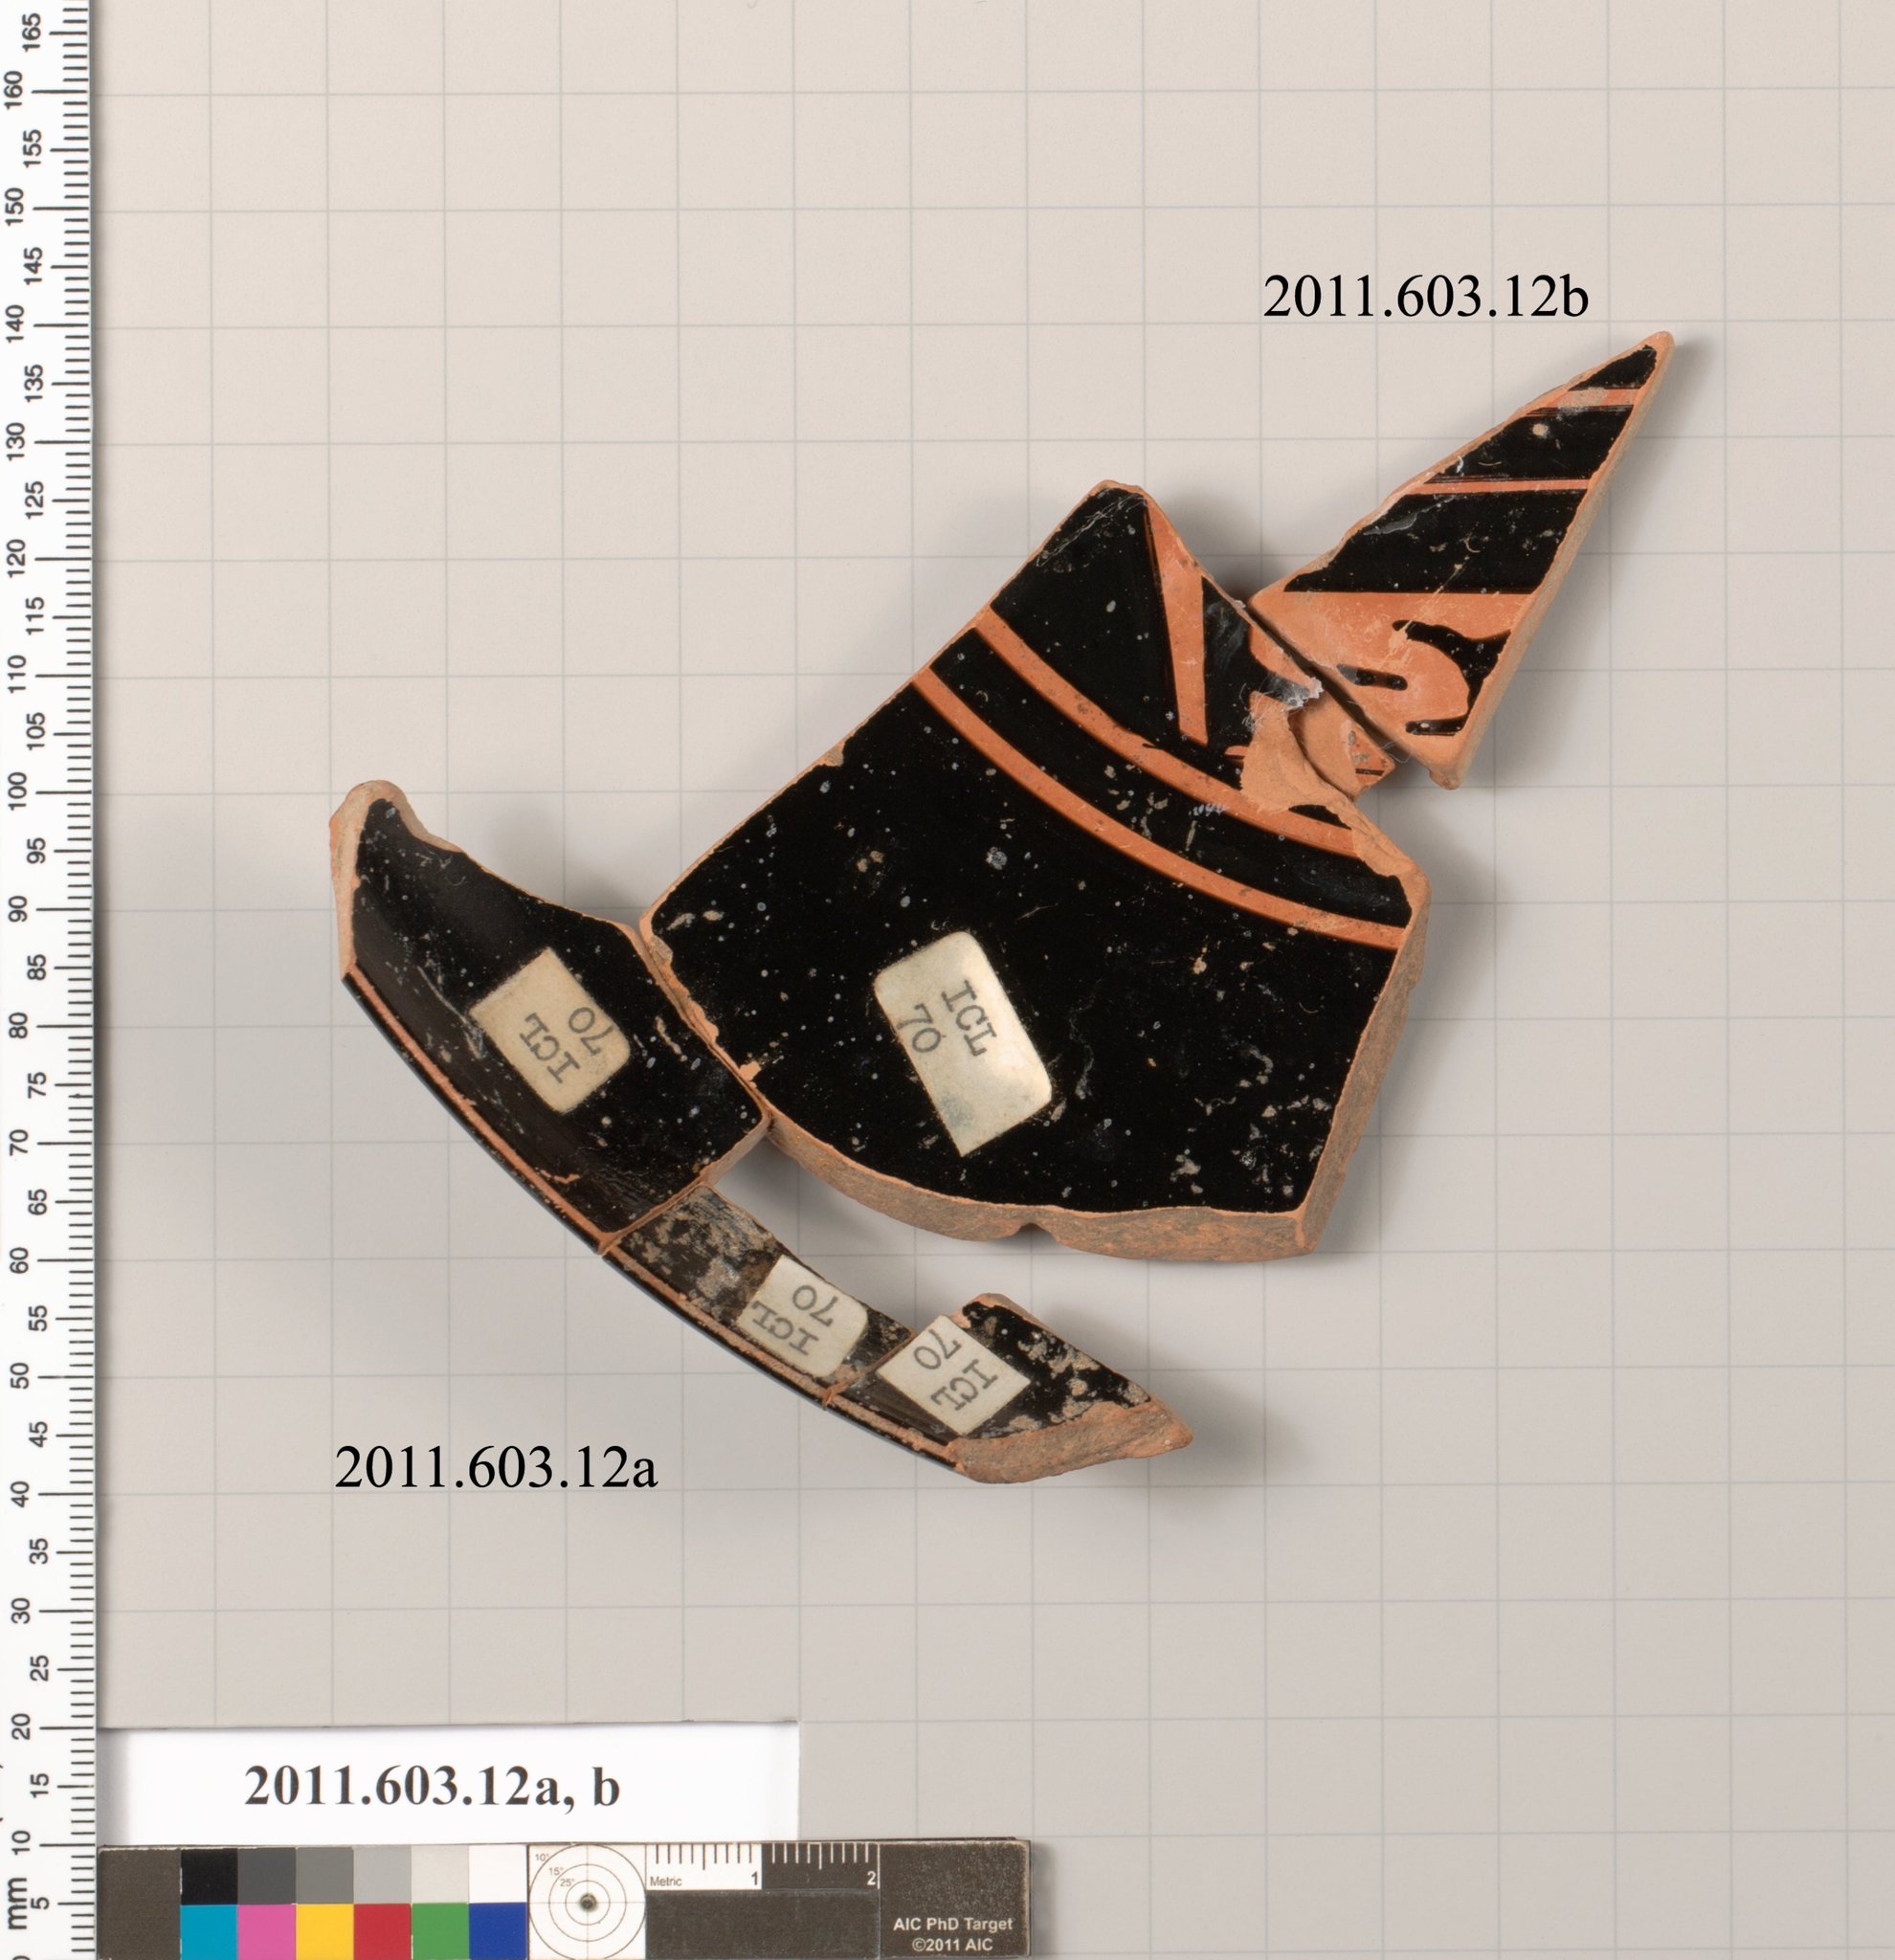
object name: kylix fragment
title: Fragments of a terracotta kylix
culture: greek, attic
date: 467-435 BCE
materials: terracotta